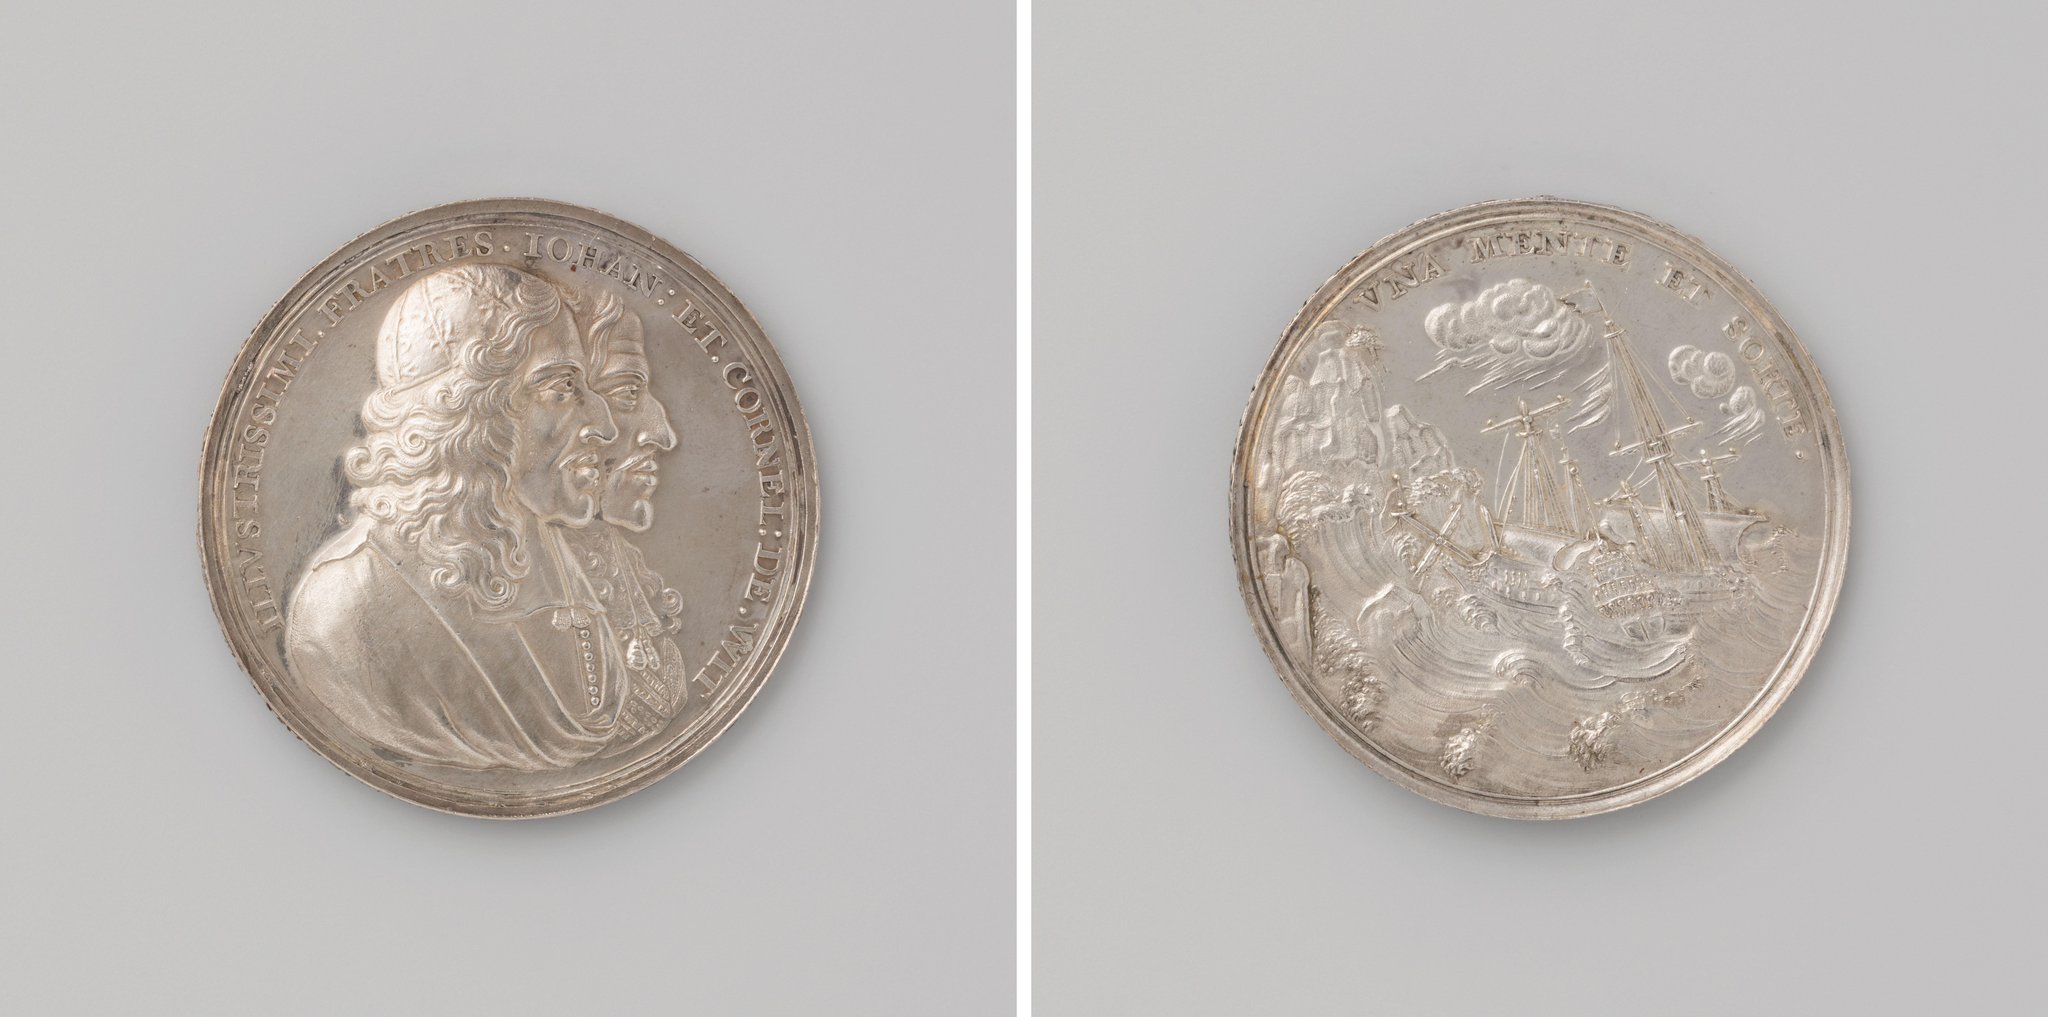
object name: history medal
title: Moord op de gebroeders de Witt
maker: Anonymous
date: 1672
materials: silver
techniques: striking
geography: netherlands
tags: dordrecht, cornelis de witt, johan de witt, the hague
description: Zilveren penning. Voorzijde: borststuk van twee mannen binnen omschrift. Keerzijde: twee schepen die in zware storm op rotsen te pletter slaan binnen omschrift; randschrift